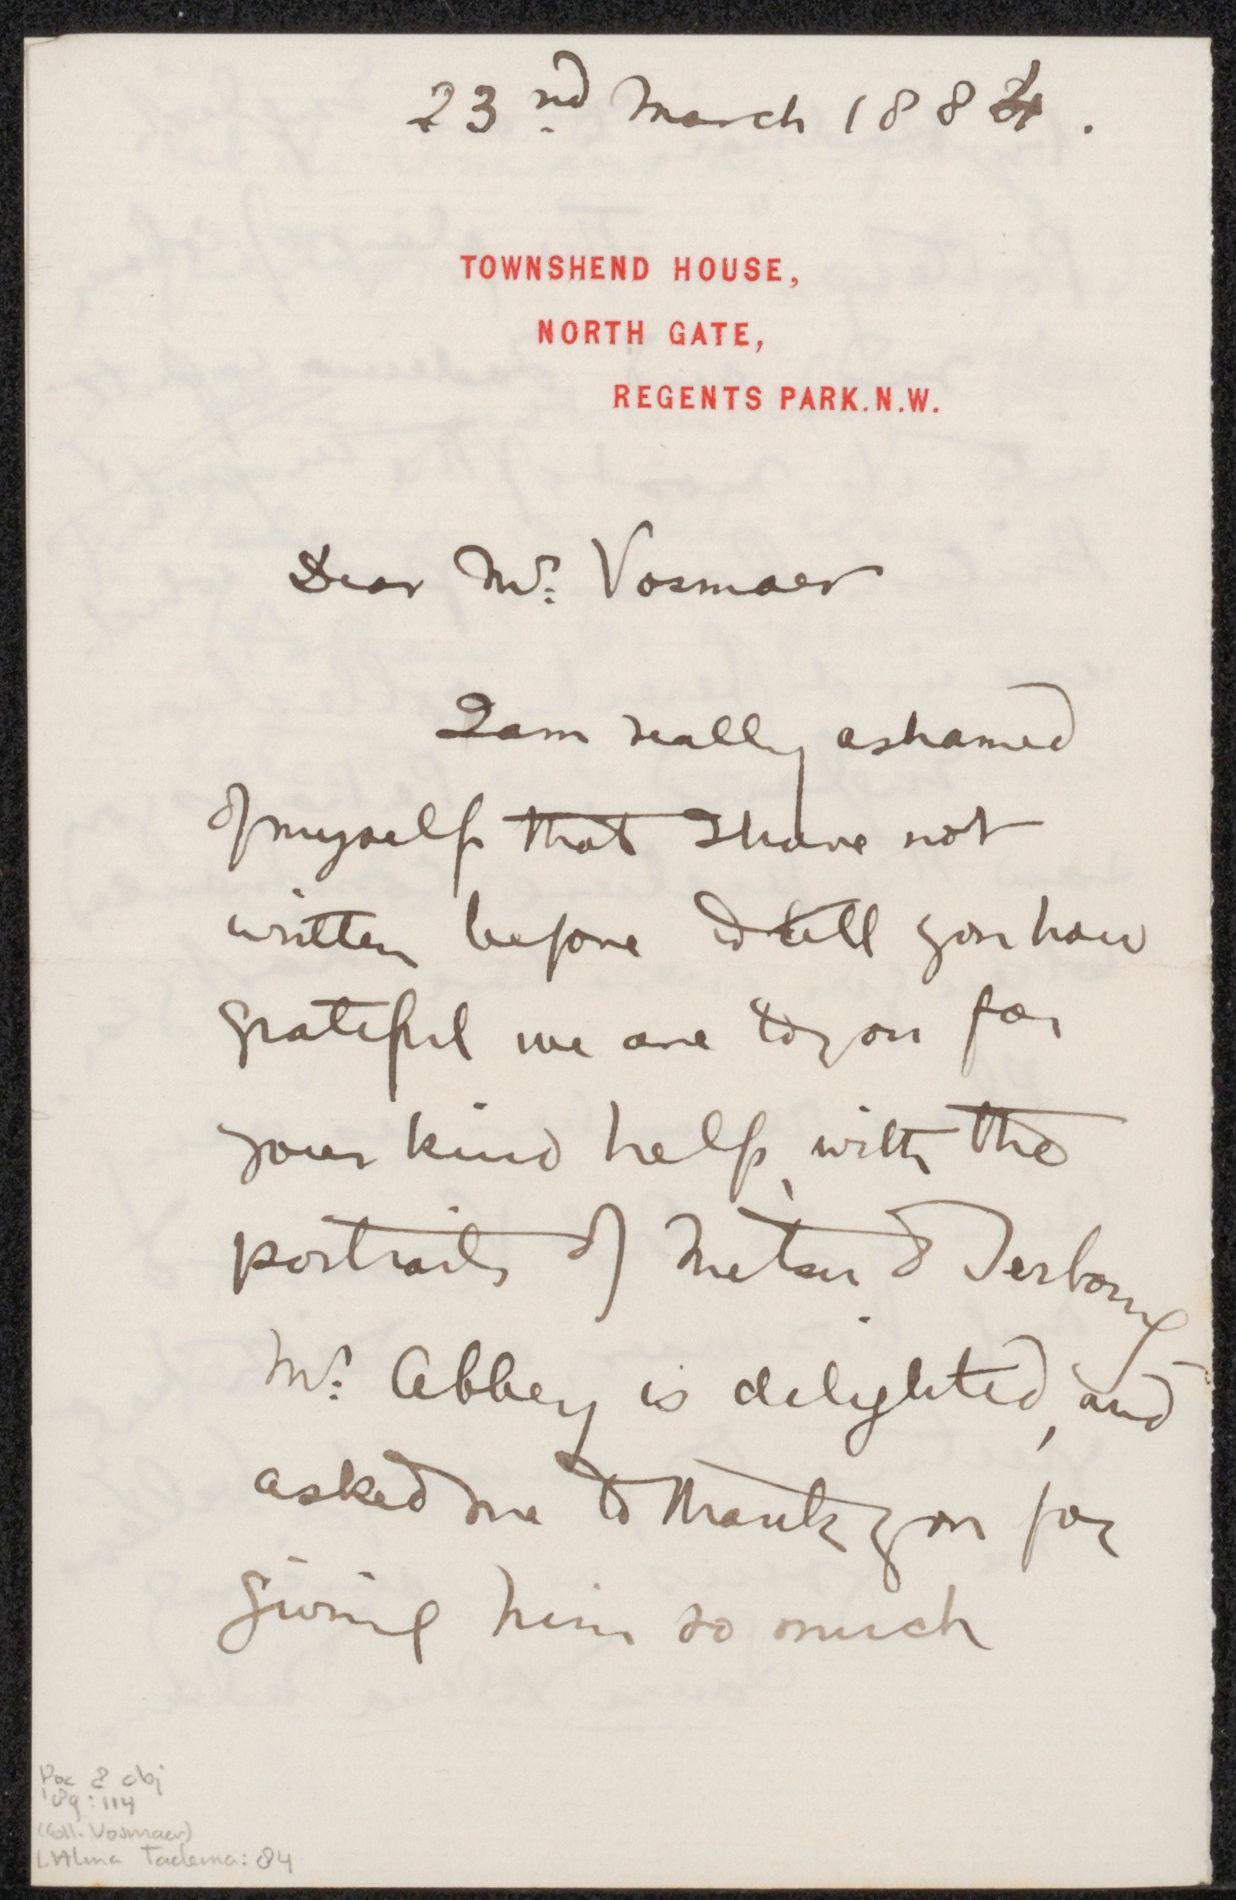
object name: letter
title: Brief aan Carel Vosmaer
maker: laura theresa alma tadema (lady)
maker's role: painter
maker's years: 1852-1909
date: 1884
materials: ink, paper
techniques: pen, printing, writing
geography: london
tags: the hague, print maker, draughtsman, carel vosmaer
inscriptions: watermark